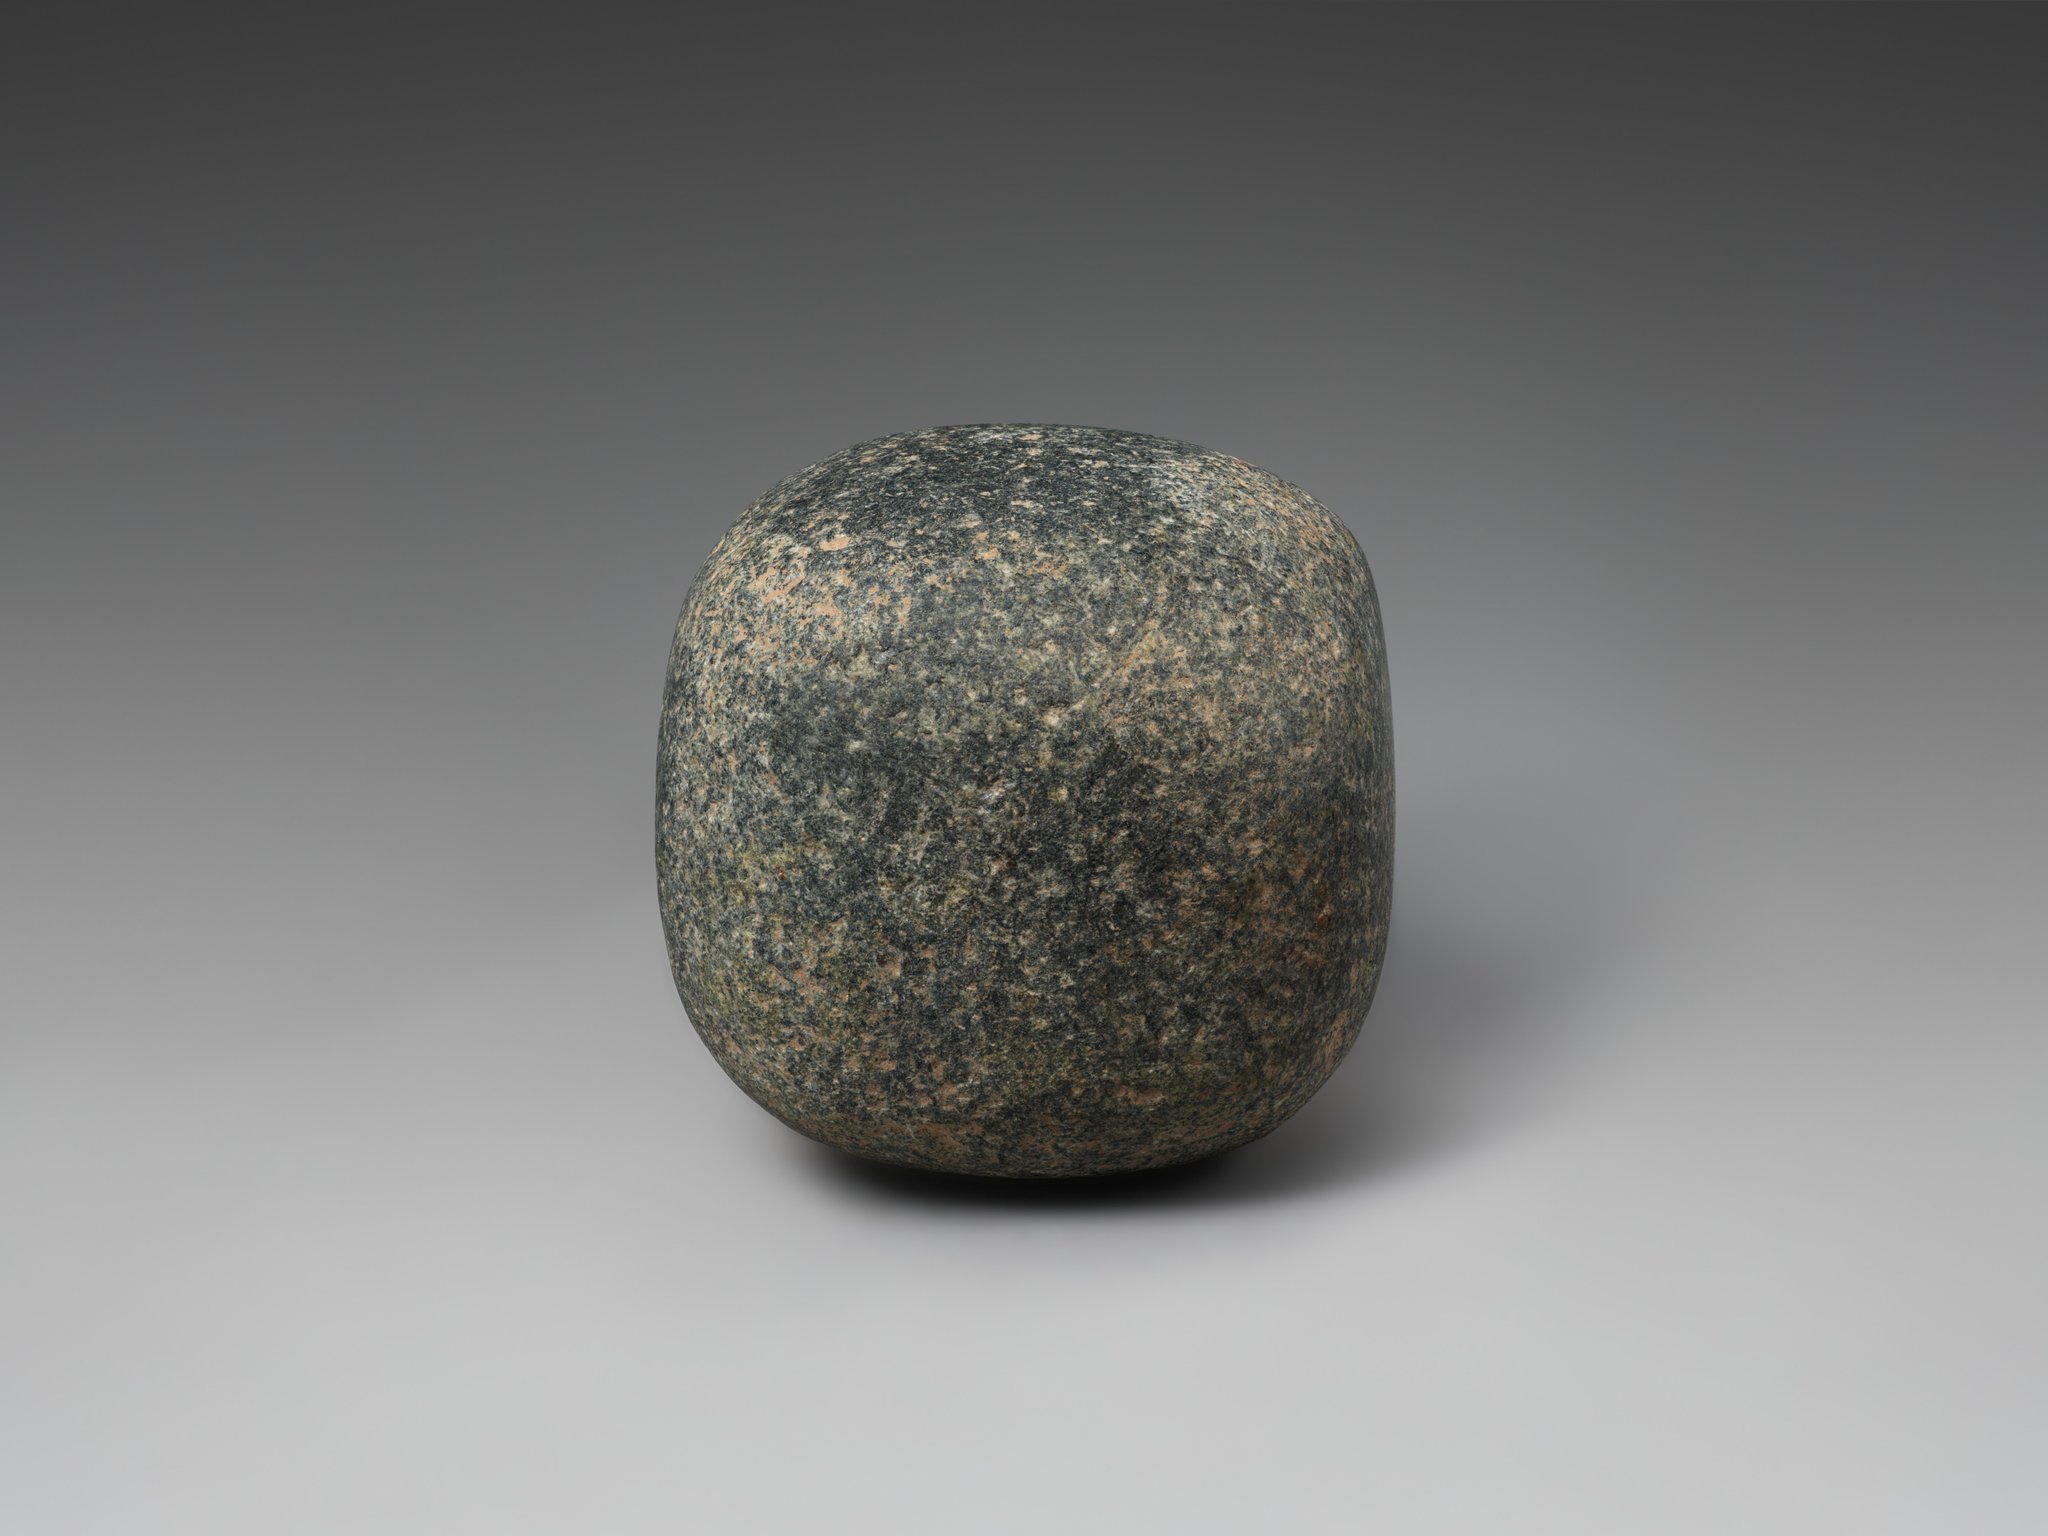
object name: weight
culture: sasanian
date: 201-700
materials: stone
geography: iran